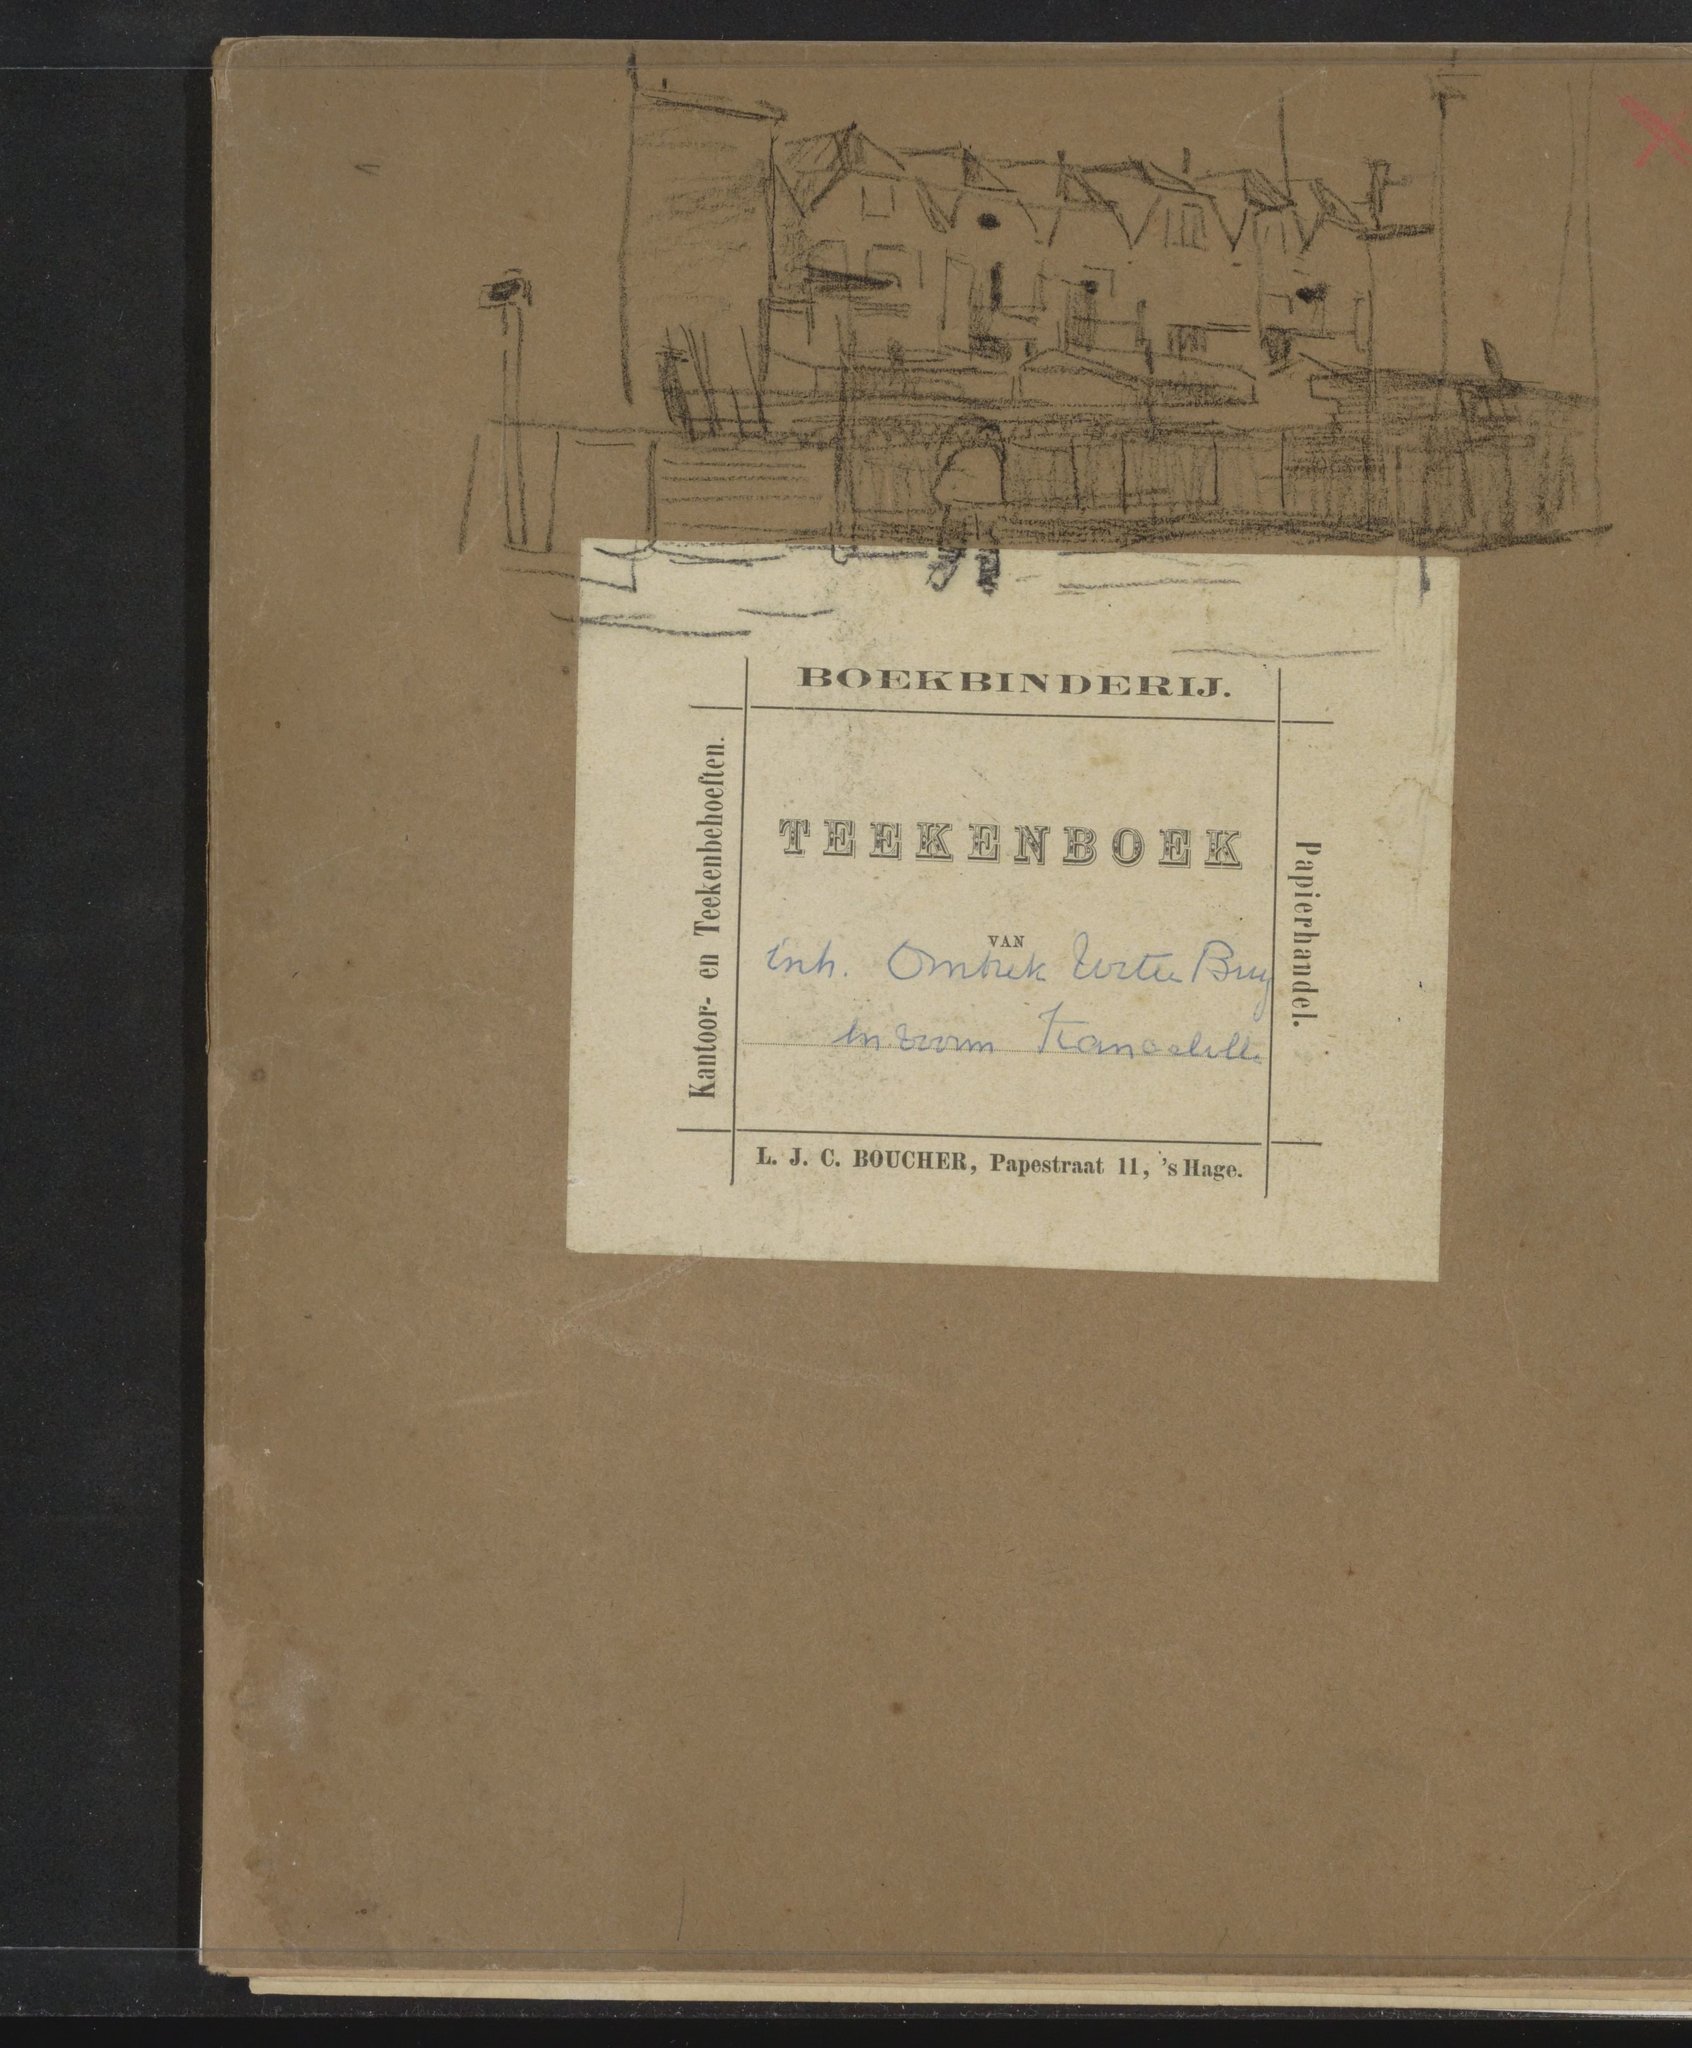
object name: sketchbook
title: Schetsboek met 19 bladen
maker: willem bastiaan tholen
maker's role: draughtsman, painter, print maker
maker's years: 1860-1931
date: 1890-1931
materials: cardboard, chalk, paper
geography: the hague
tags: head (human), street (+ city(-scape) with figures, staffage), the hague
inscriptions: retailer's mark: ‘Kantoor- en Teekenbehoeften./ BOEKBINDERIJ./ Papierhandel./ L.J.C. BOUCHER, Papestraat 11, 's Hage/ TEEKENBOEK/ van’, annotation: ‘inh. Omtrek Witte Brug/ en zoom Kanaalvilla?’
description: Schetsboek bestaande uit 19 bladen (de beschermvellen zijn meegenomen in de nummering) met voornamelijk figuurstudies en landschappen, vermoedelijk getekend in de omgeving van de Witte Brug in Den Haag. Op de voorzijde van de omslag van het schetsboek een straatgezicht met een figuur. Op de achterzijde van de omslag een aanzet tot een kop.